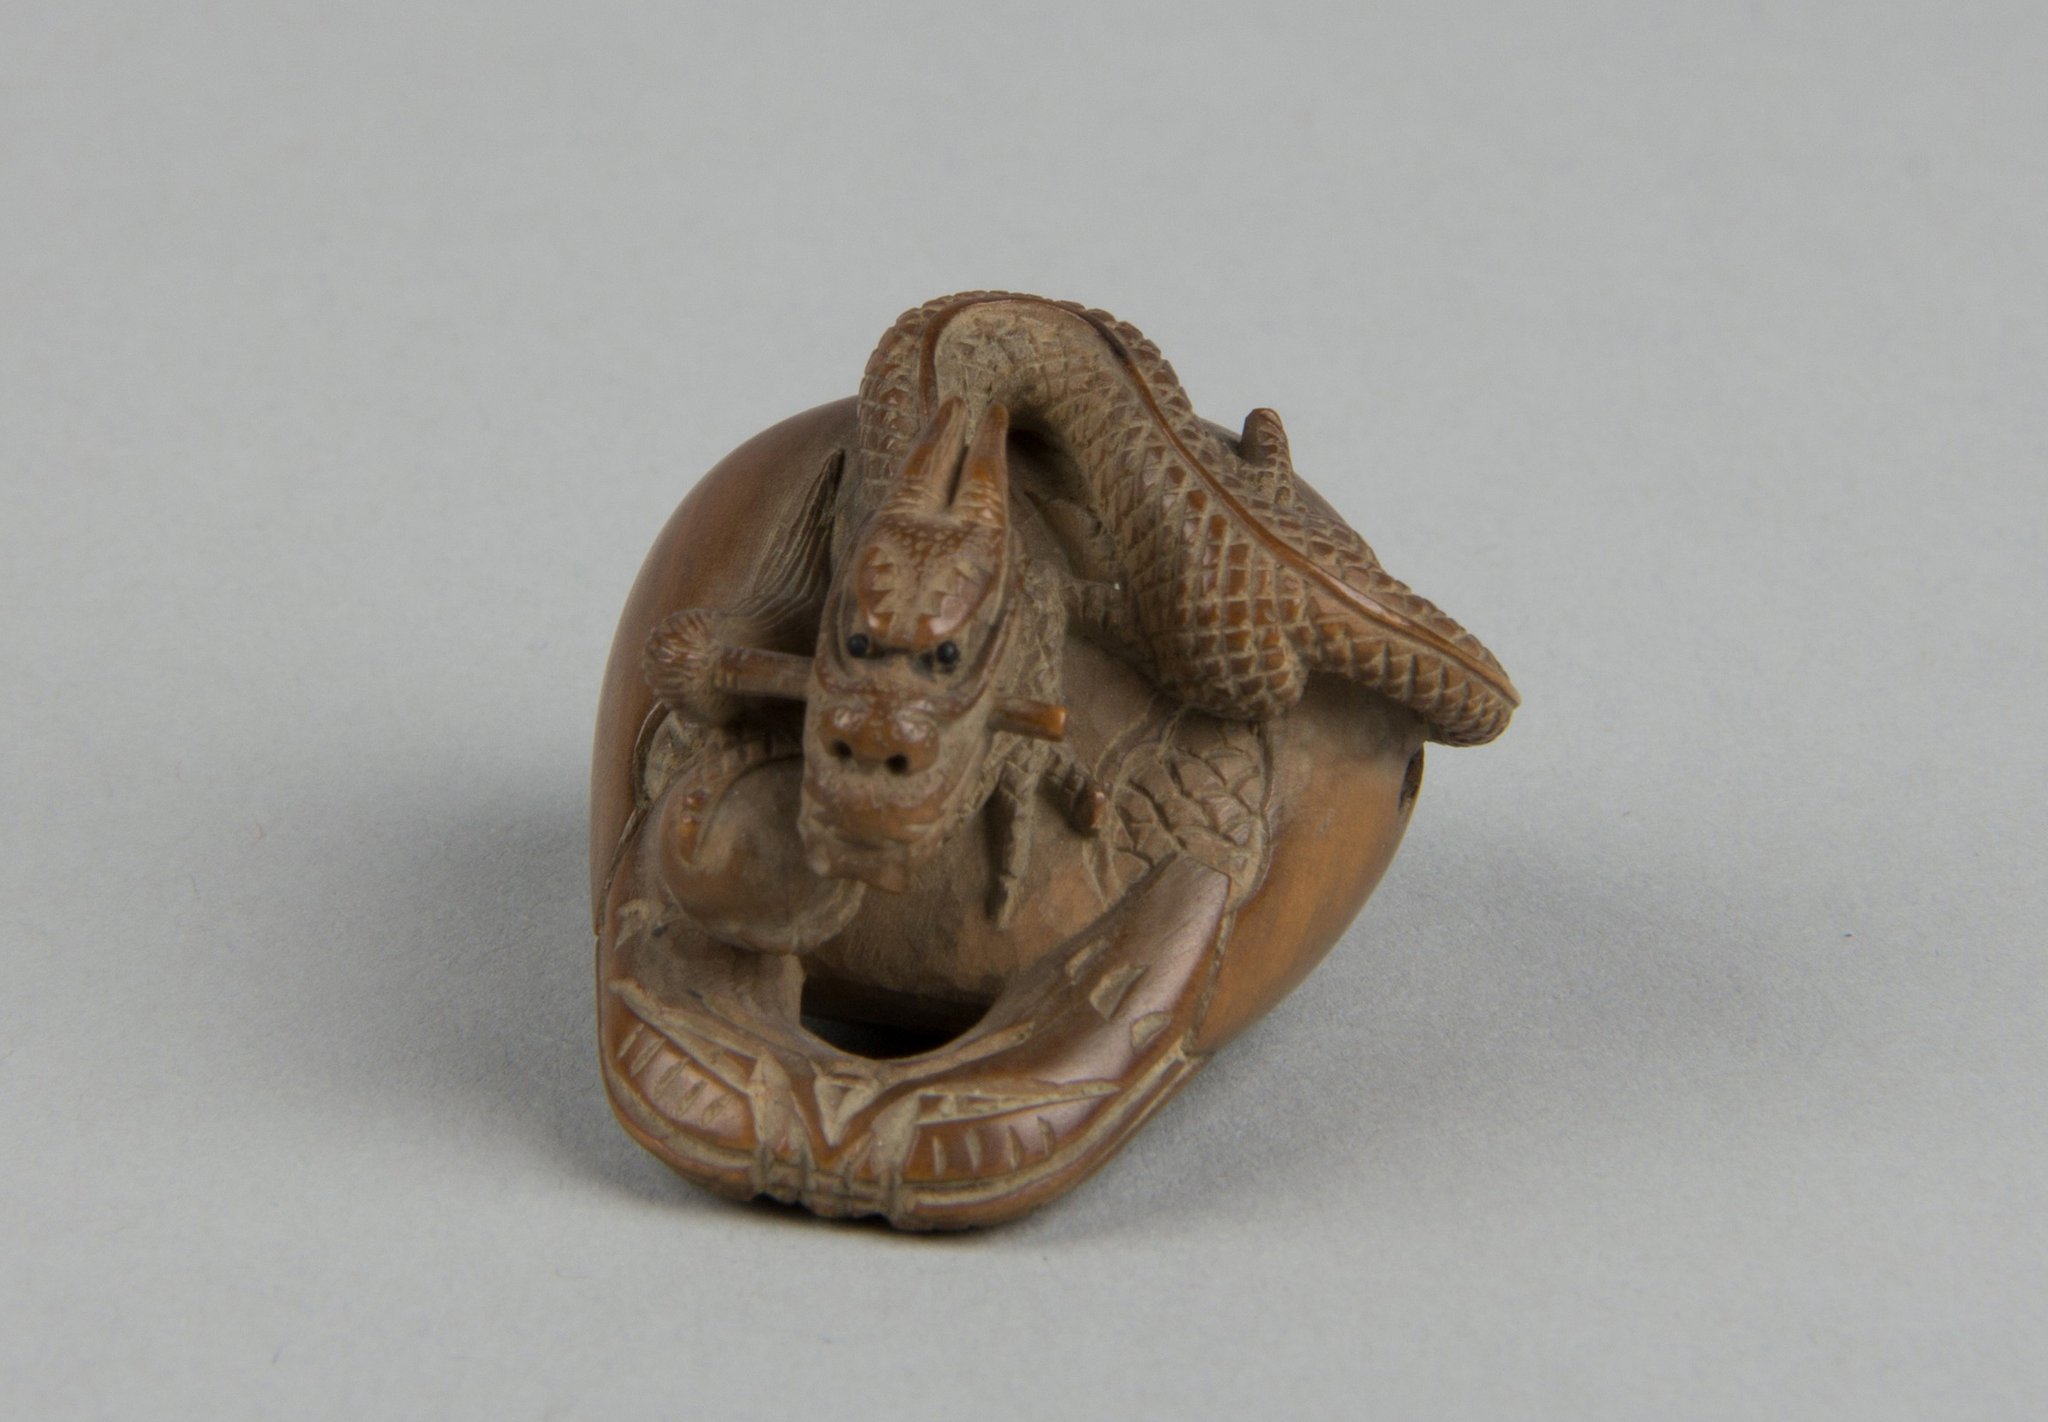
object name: netsuke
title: Netsuke of Dragon in a Nut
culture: japanese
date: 1801-1900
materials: wood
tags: dragons